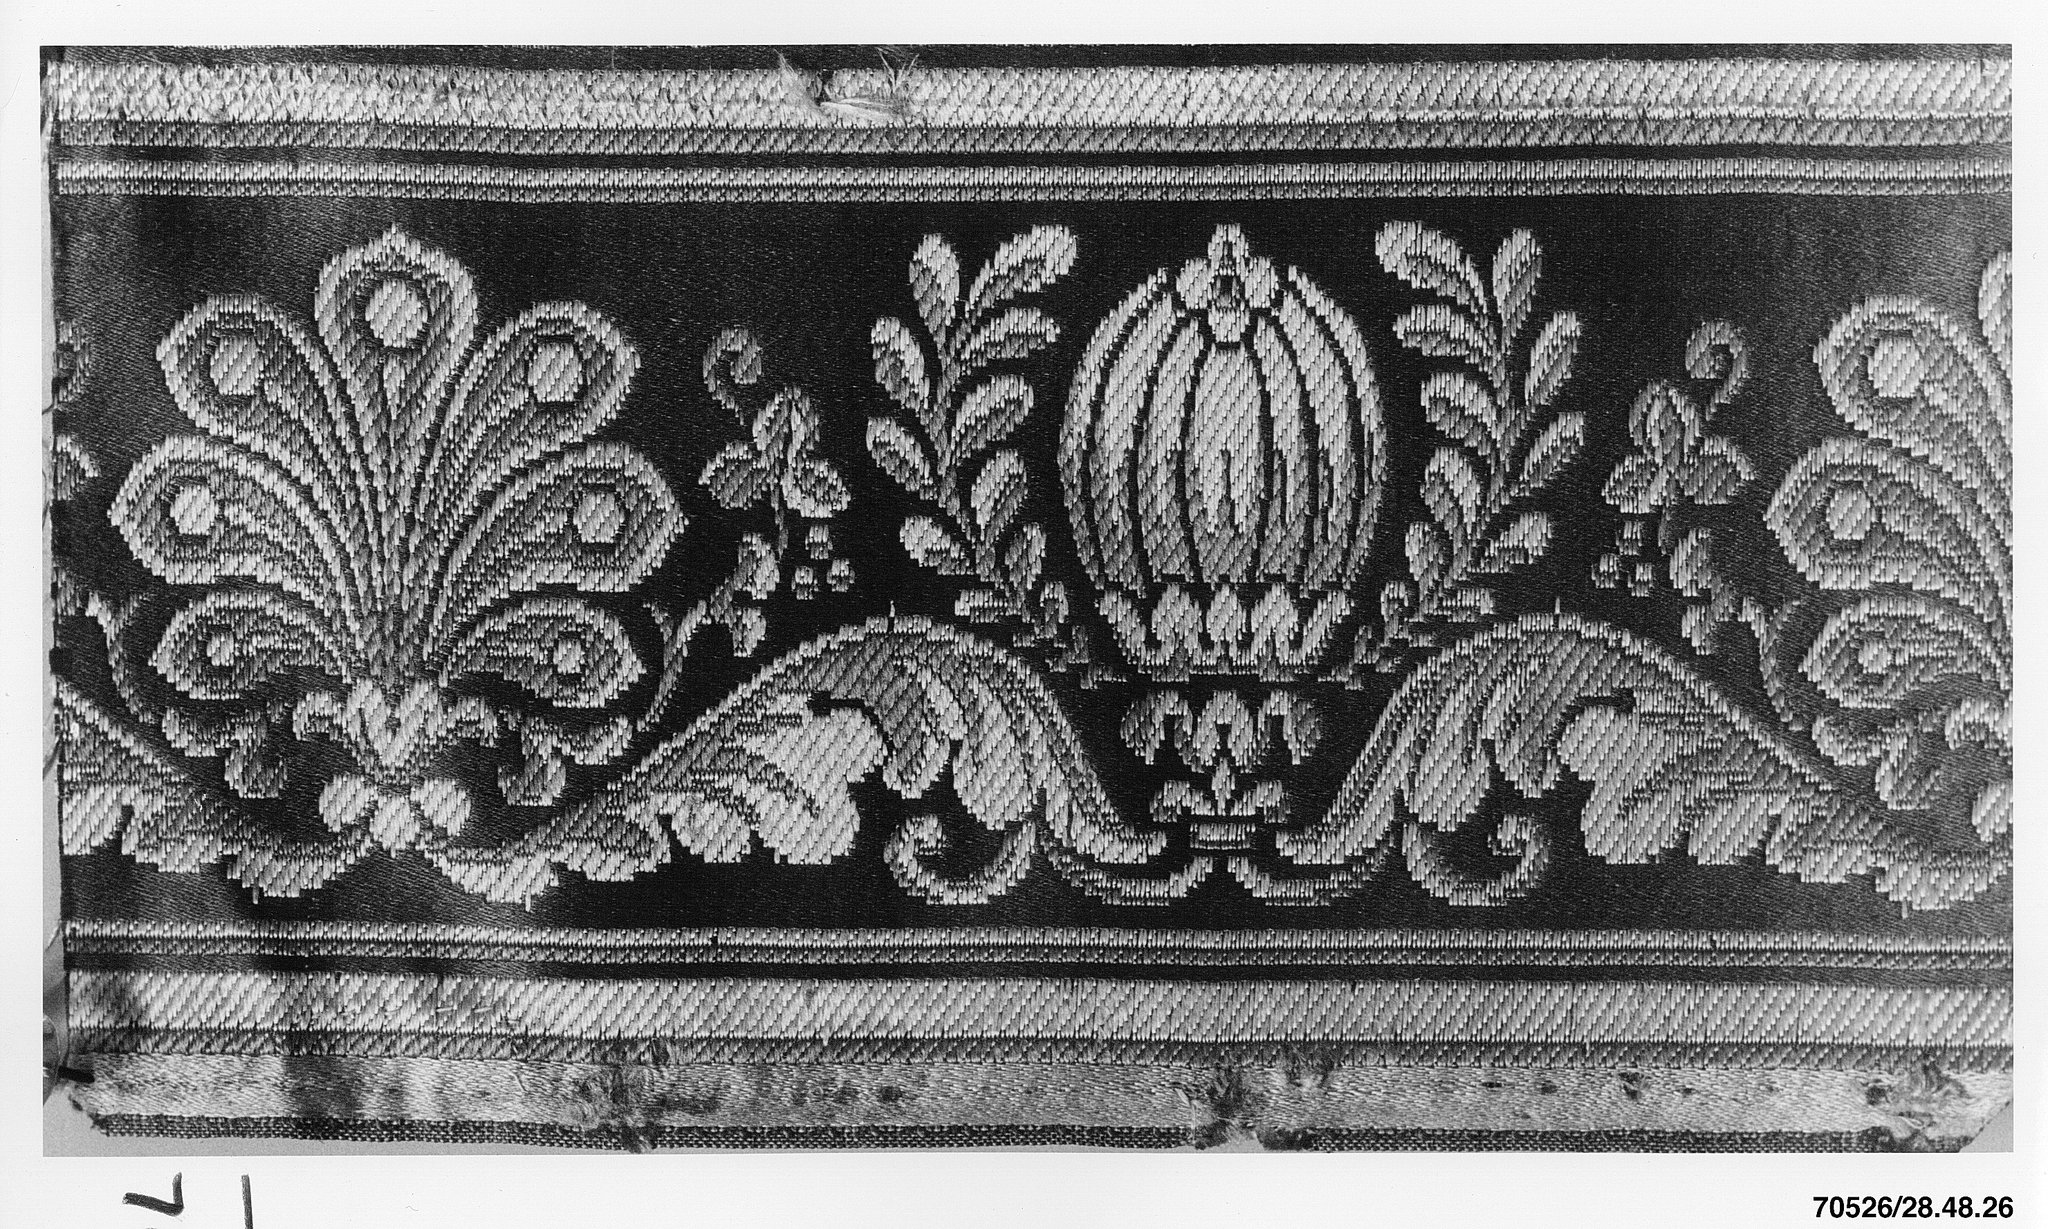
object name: border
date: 1801-1900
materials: silk